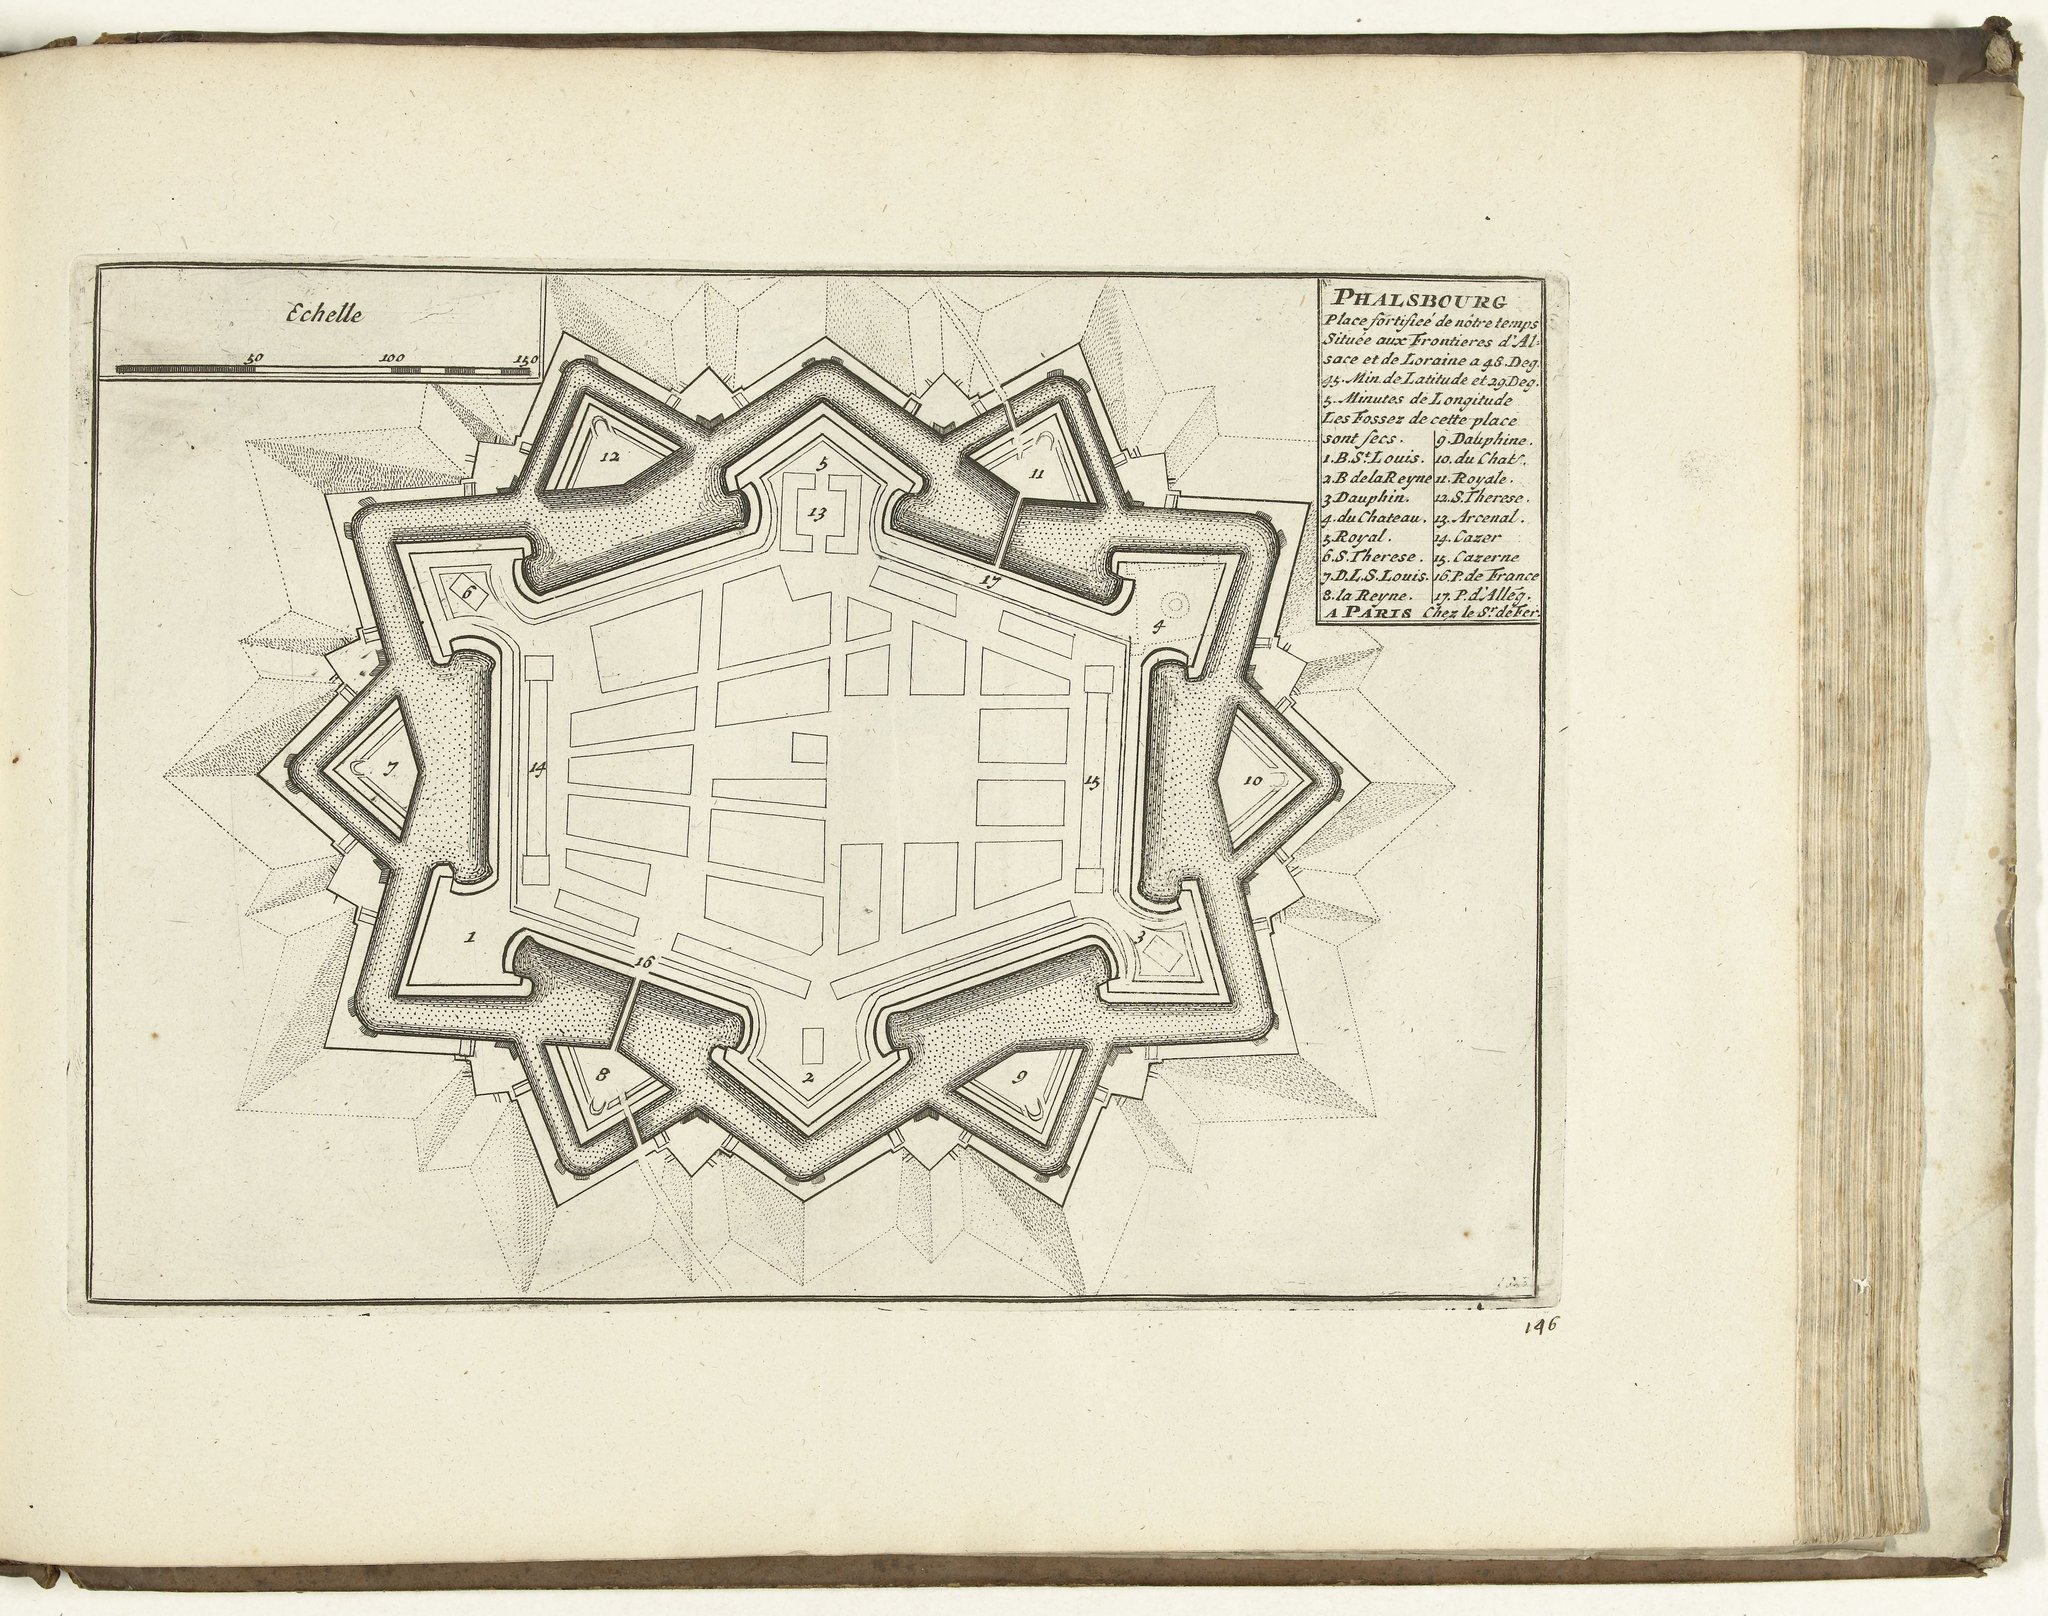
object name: print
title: Plattegrond van Phalsbourg, 1726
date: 1726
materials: paper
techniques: etching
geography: paris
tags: fortress, maps of cities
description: Plattegrond van de versterkingen om de stad Phalsbourg. Plaat nr. 146 in deel VII van het prentwerk: Les Forces de l'Europe, Asie, Afrique et Amerique ... Comme aussi les Cartes des Côtes de France et d'Espagne uit 1726, dit eerste deel met 238 met de hand genummerde platen van vermaarde sterke steden en vestingen in het kader van de Spaanse Successieoorlog 1701-1713. Voor het merendeel zijn deze platen gekopieerd naar de anonieme Franse platen van vermaarde sterke steden en vestingen: in Les forces de l'Europe en in: Le theatre de la guerre, dans les Pays-Bas, beide oorspronkelijk uitgegeven door Nicolas de Fer te Parijs (1693-1697) in het kader van de Negenjarige Oorlog. Titels en opschriften in het Frans. Rechtsonder sporen van het weggepolijste nummer: 125.